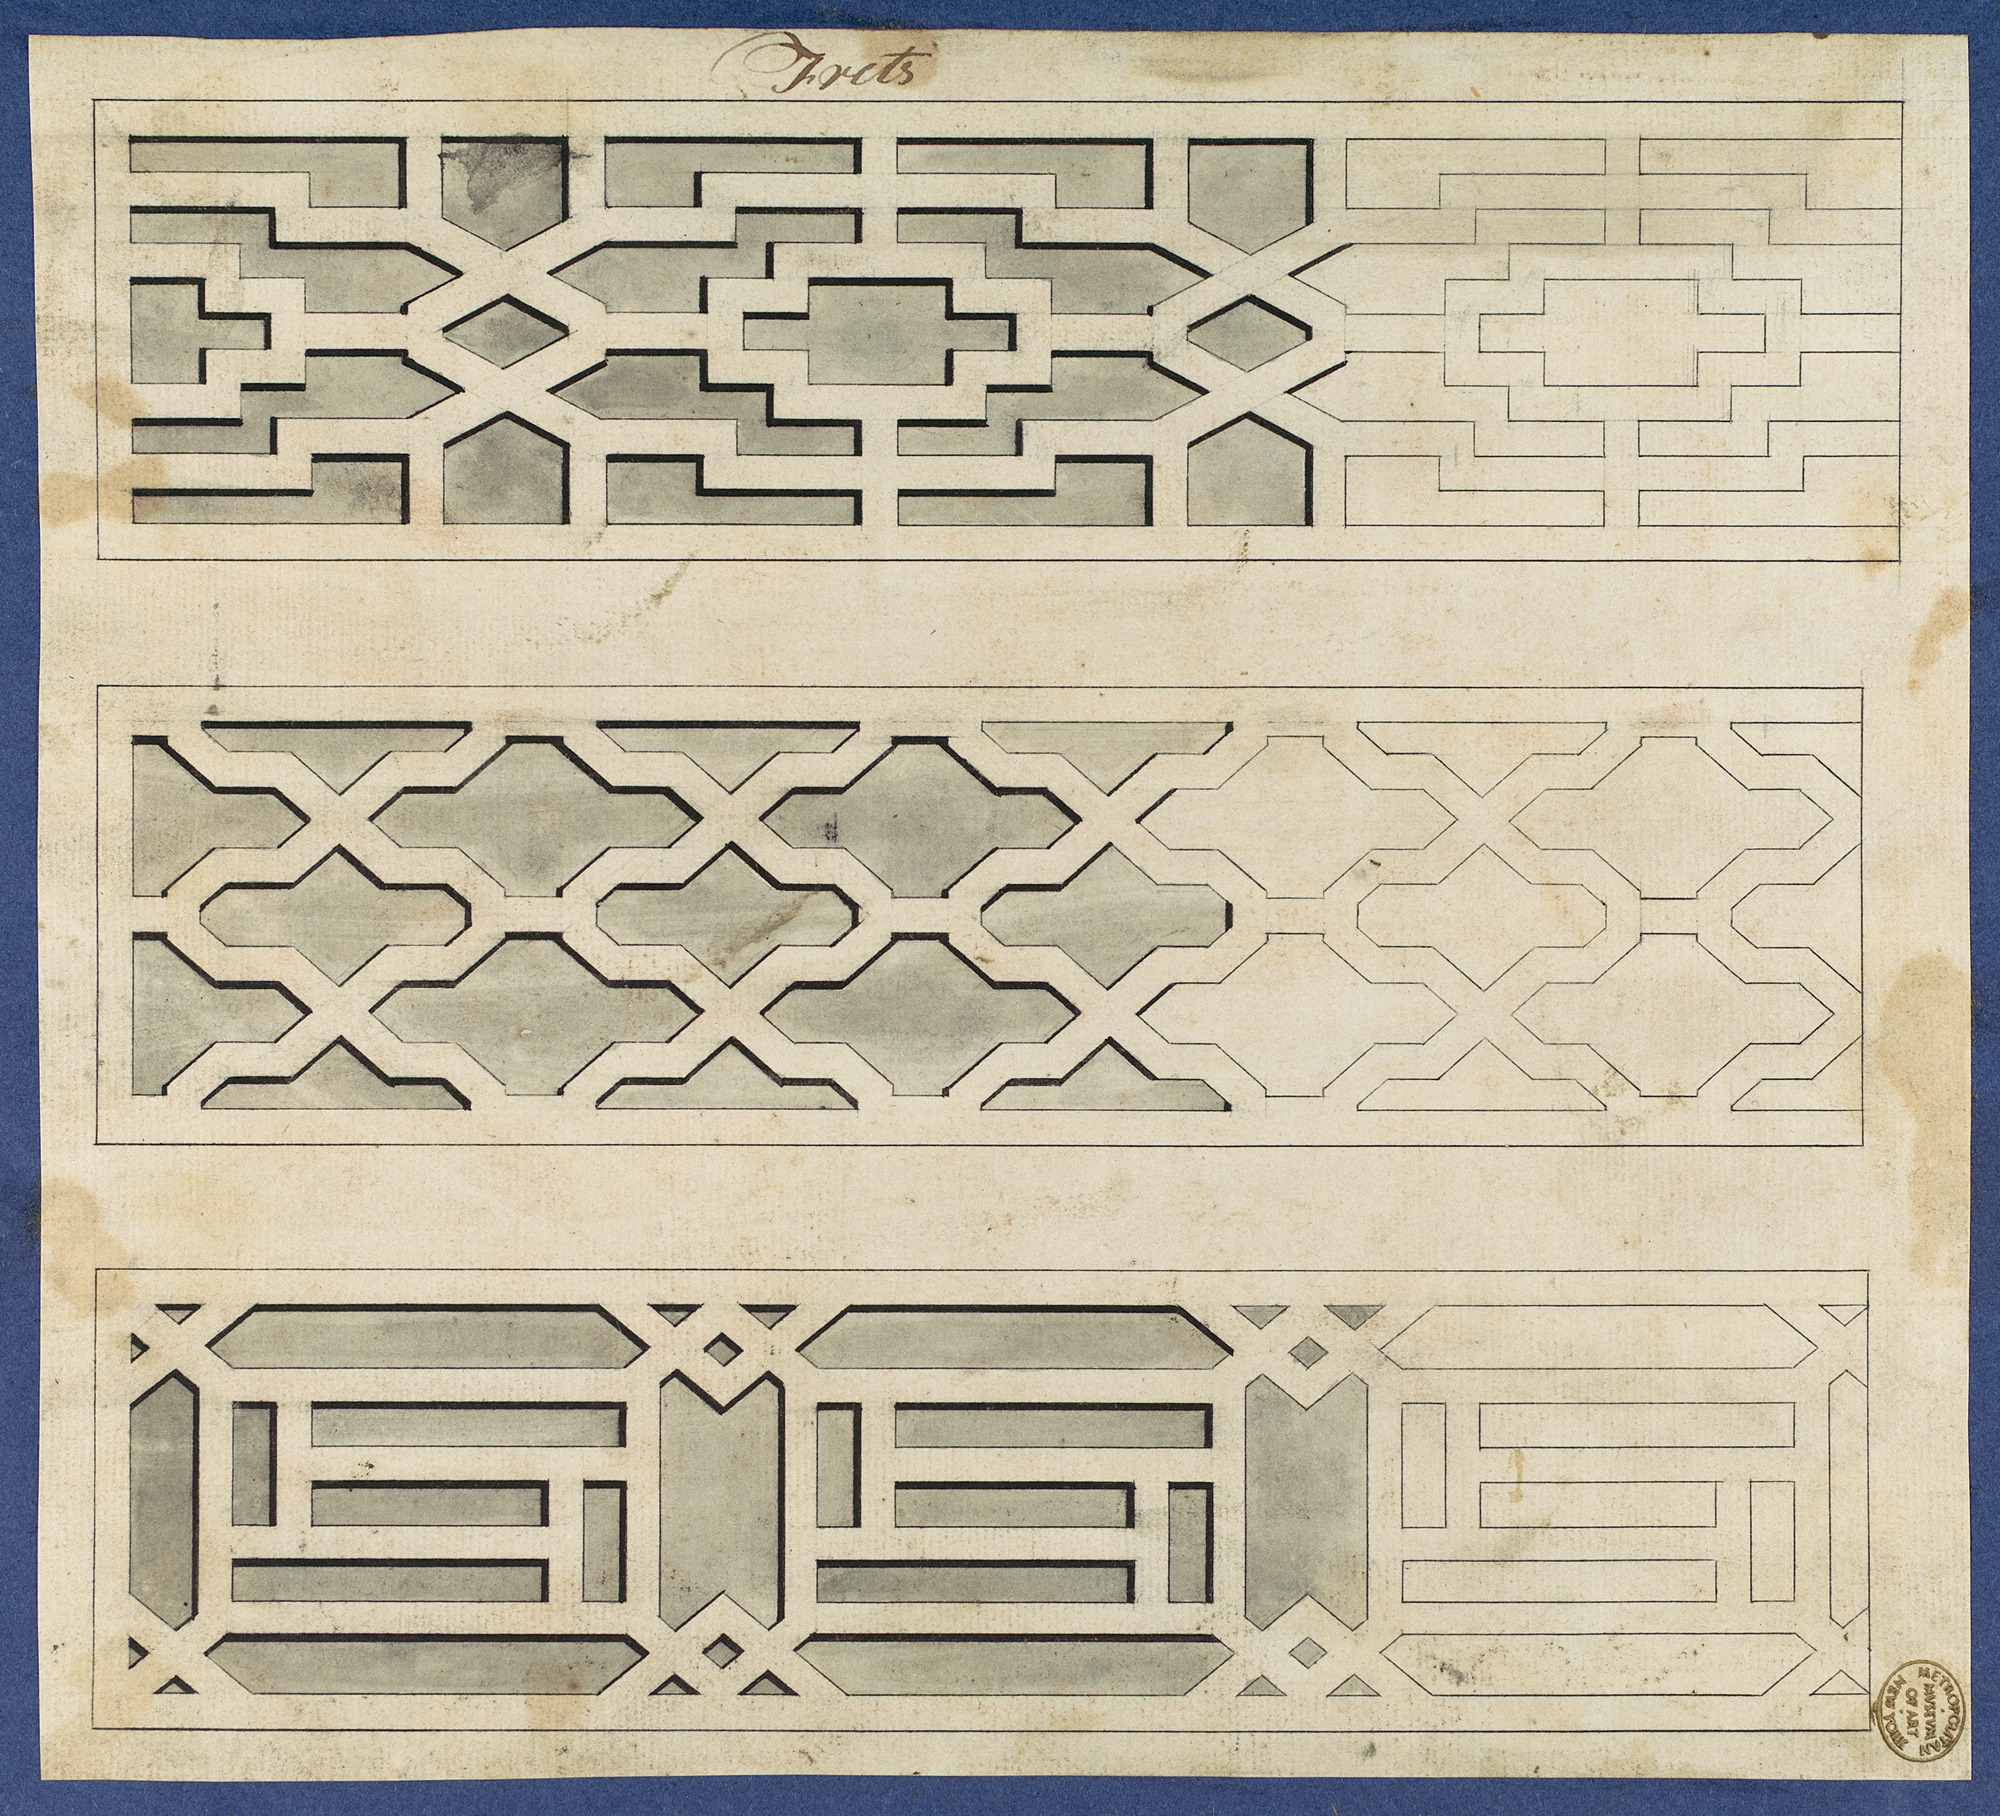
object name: drawing ornament architecture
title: Frets, from Chippendale Drawings, Vol. II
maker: thomas chippendale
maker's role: artist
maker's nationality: british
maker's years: 1718-1779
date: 1754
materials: ink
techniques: wash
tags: ornament